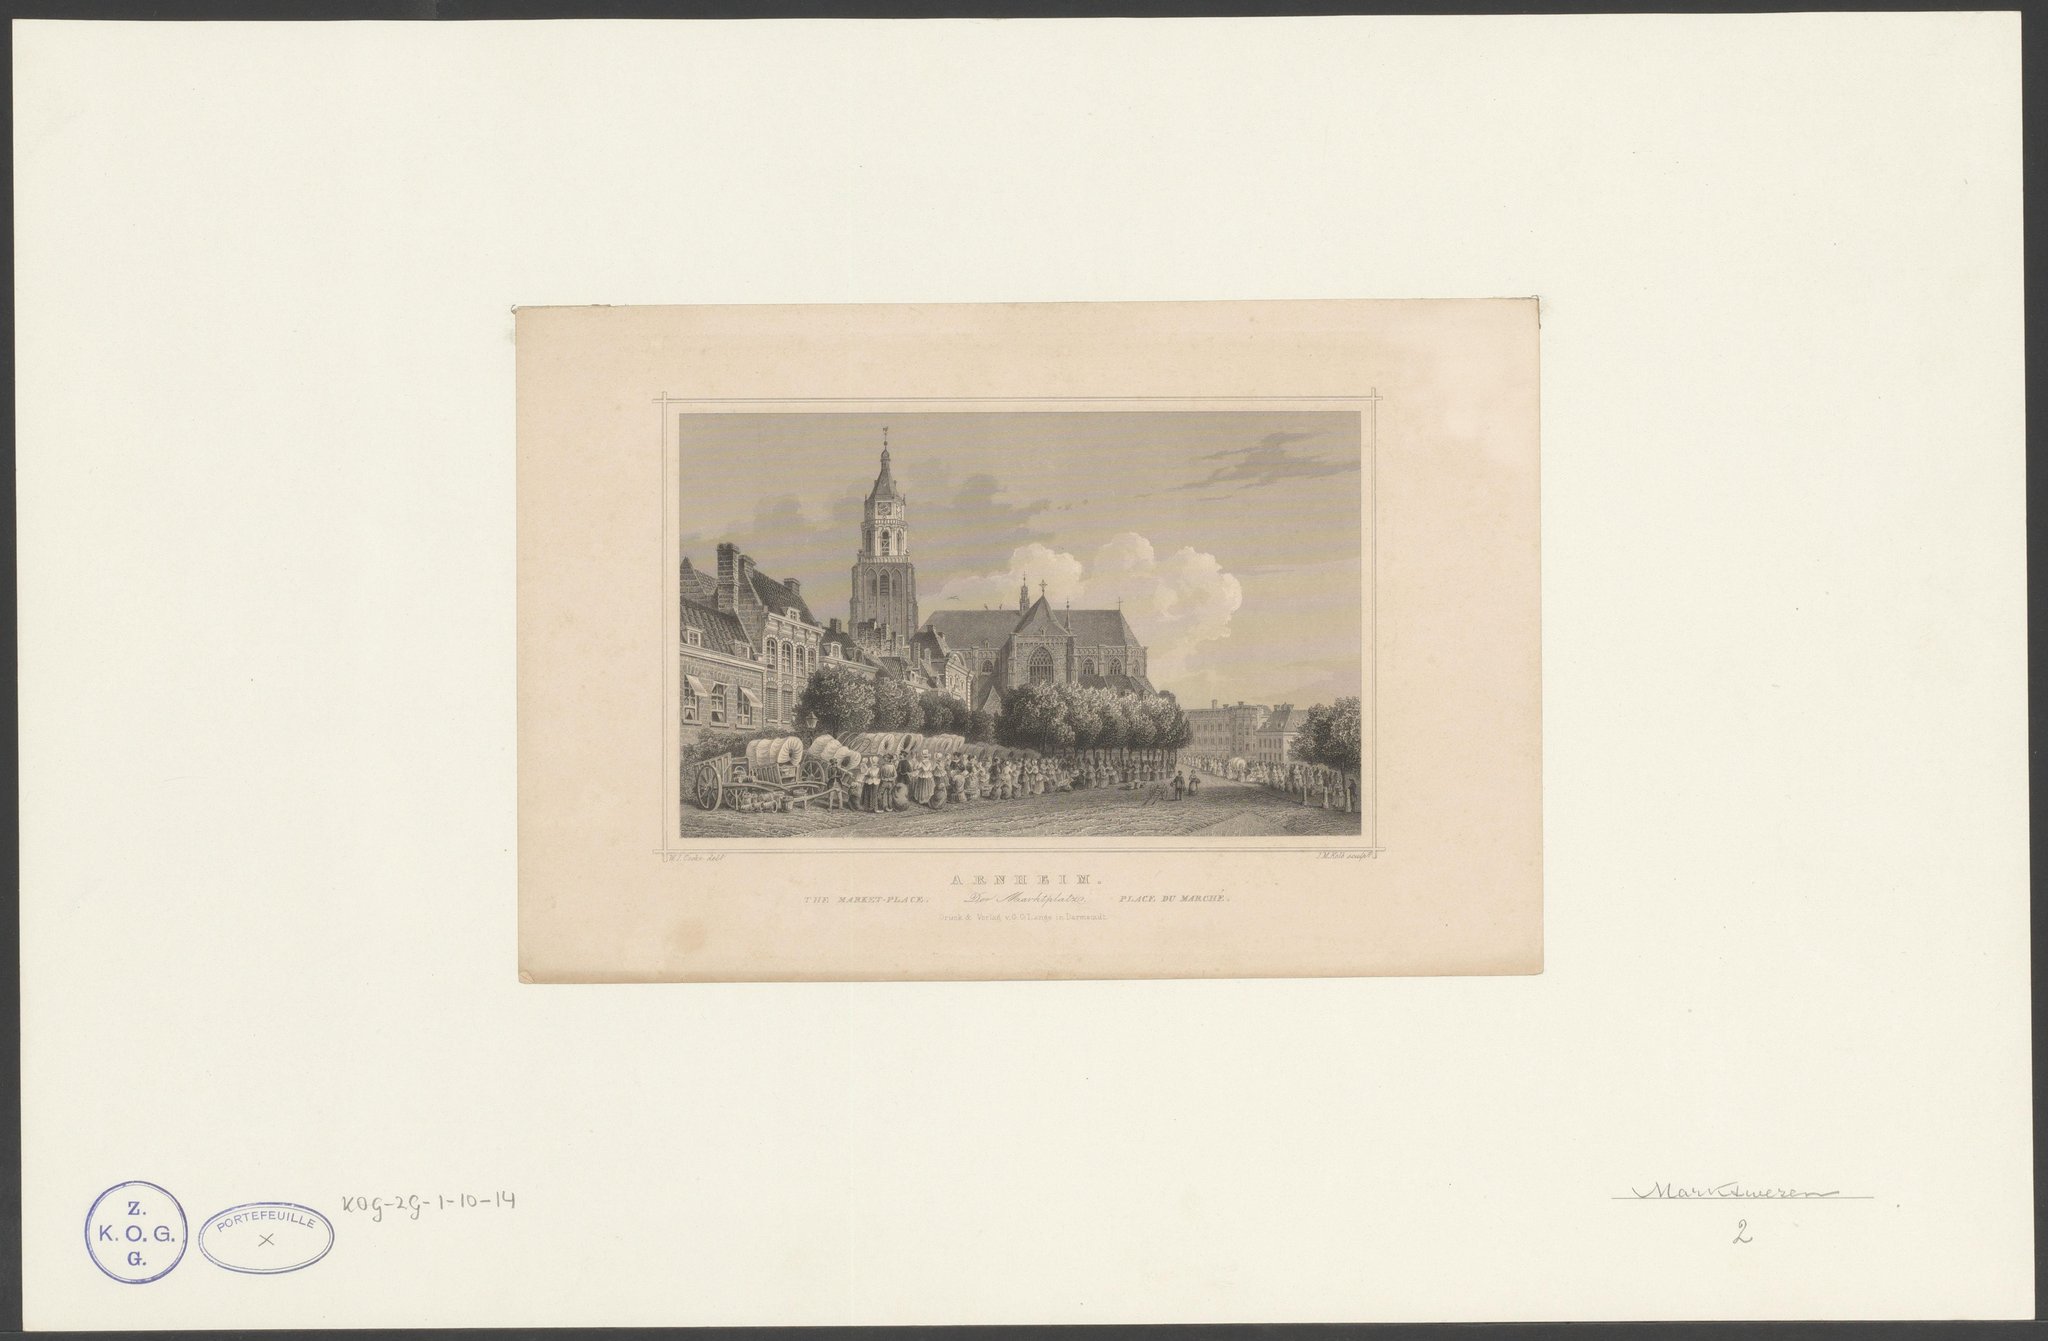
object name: print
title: Gezicht op de Grote Markt in Arnhem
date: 1835-1874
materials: paper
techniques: engraving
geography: darmstadt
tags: vegetables, market, fruits, arnhem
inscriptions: stamp, collector's mark: Lugt 1641, stamp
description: Onderwerpsrubrieken binnen de Atlas Zeden en Gewoonten: Handel, nijverheid en verkeer, Marktwezen, Arnhem.